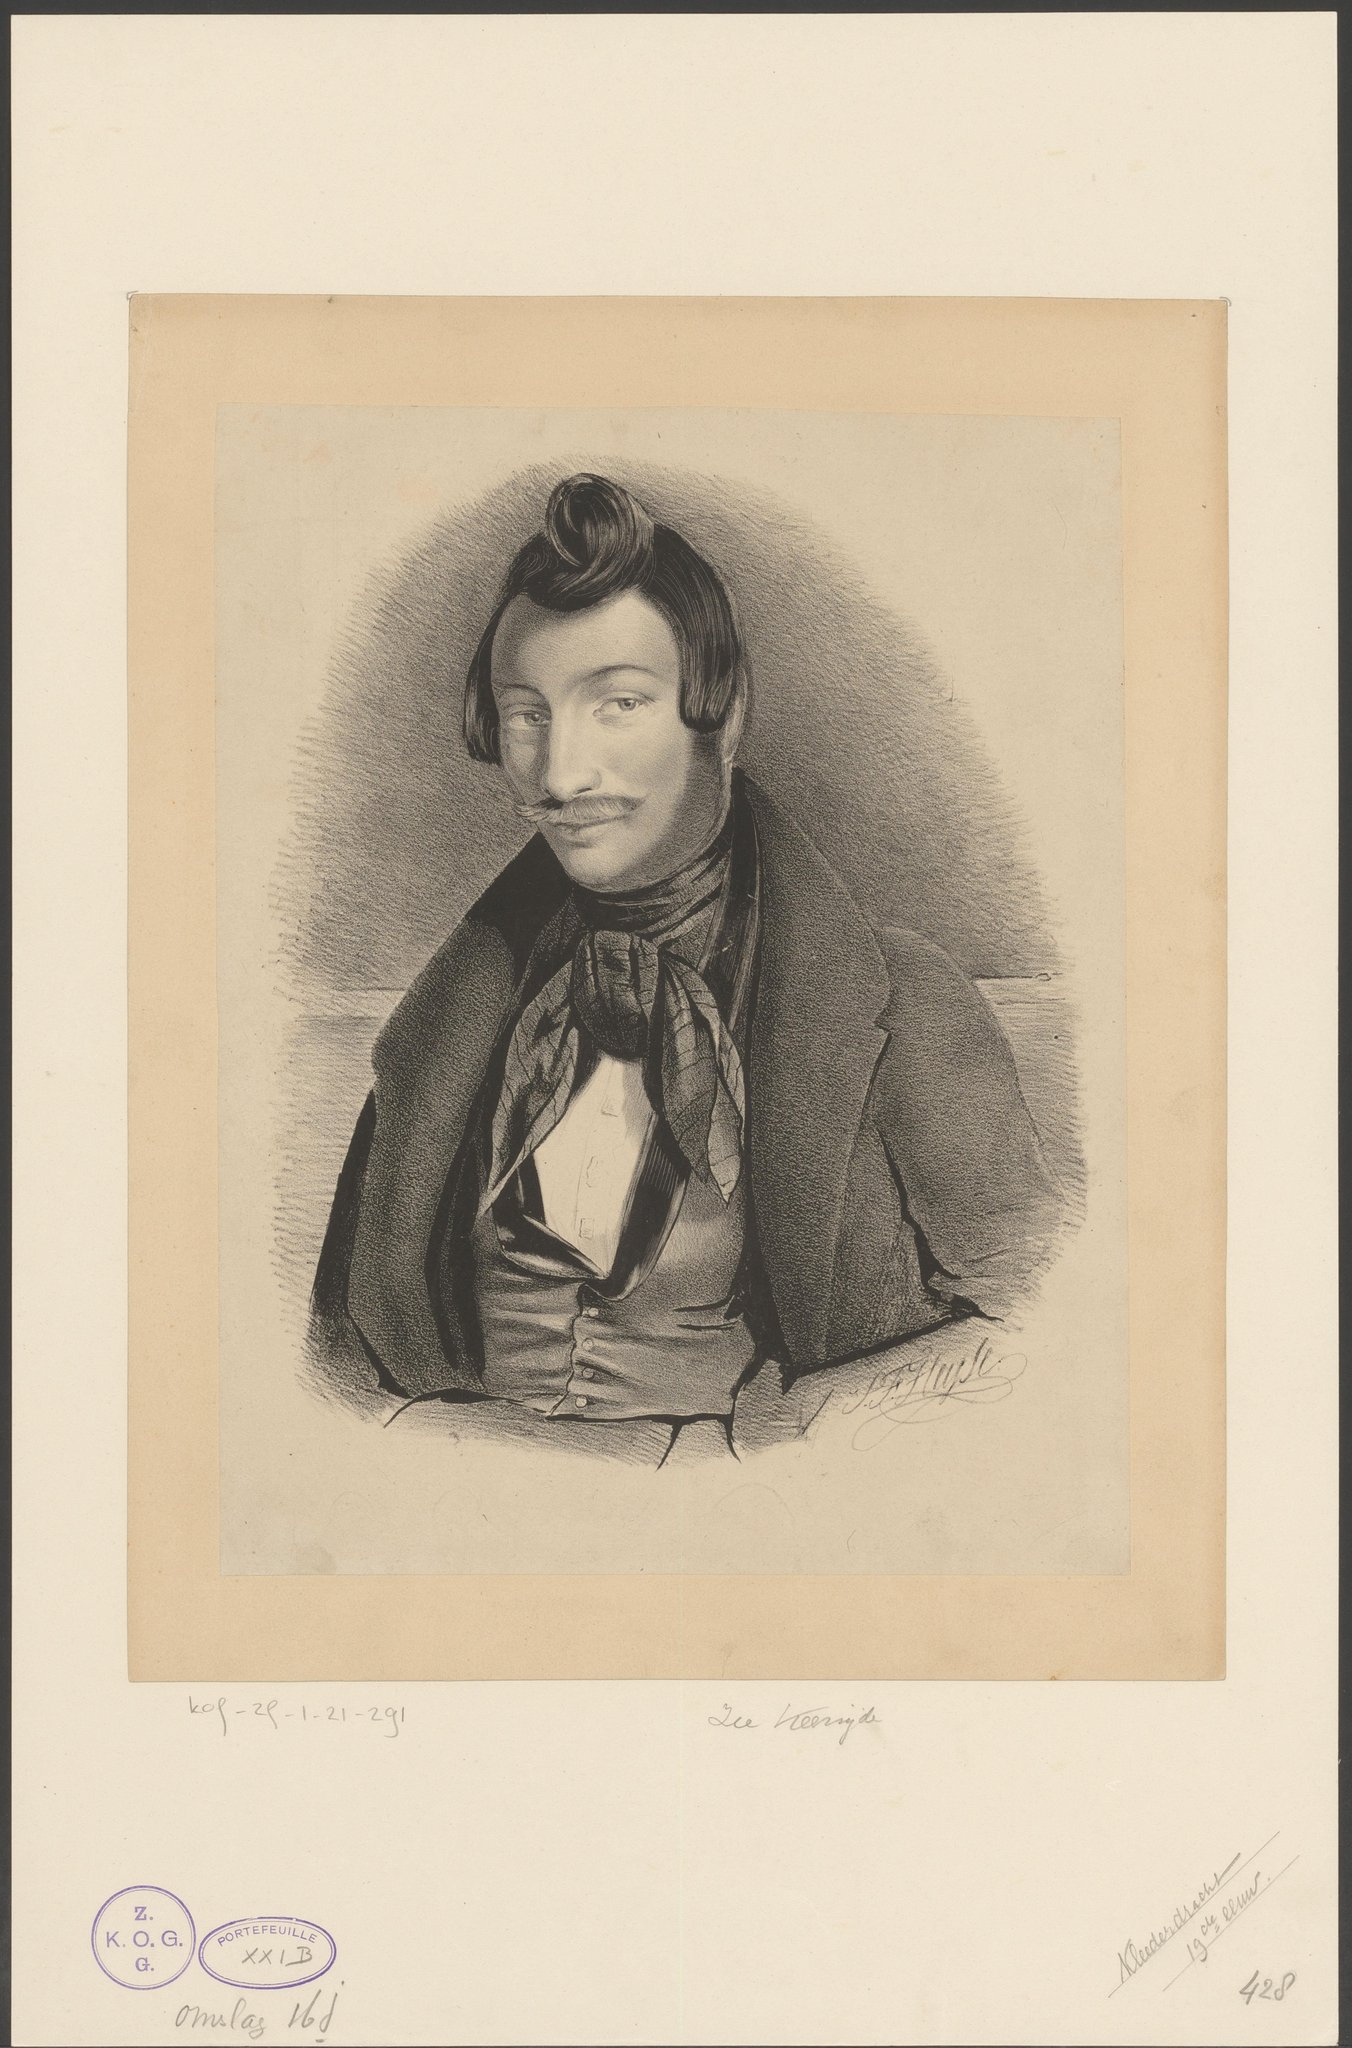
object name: print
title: Portret van Ludwig Michael Nader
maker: prosper ferdinand heyse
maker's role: print maker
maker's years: 1816-1879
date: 1826-1879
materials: paper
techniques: lithograph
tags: print maker, ludwig michael nader, historical persons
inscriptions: collector's mark: Lugt 1641, stamp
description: Onderwerpsrubrieken binnen de Atlas Zeden en Gewoonten: Zeden en Gewoonten in Engeren Zin, De Kleeding, Kleederdrachten (tijdvakken), Het midden der 19de eeuw. Mannen en vrouwen.